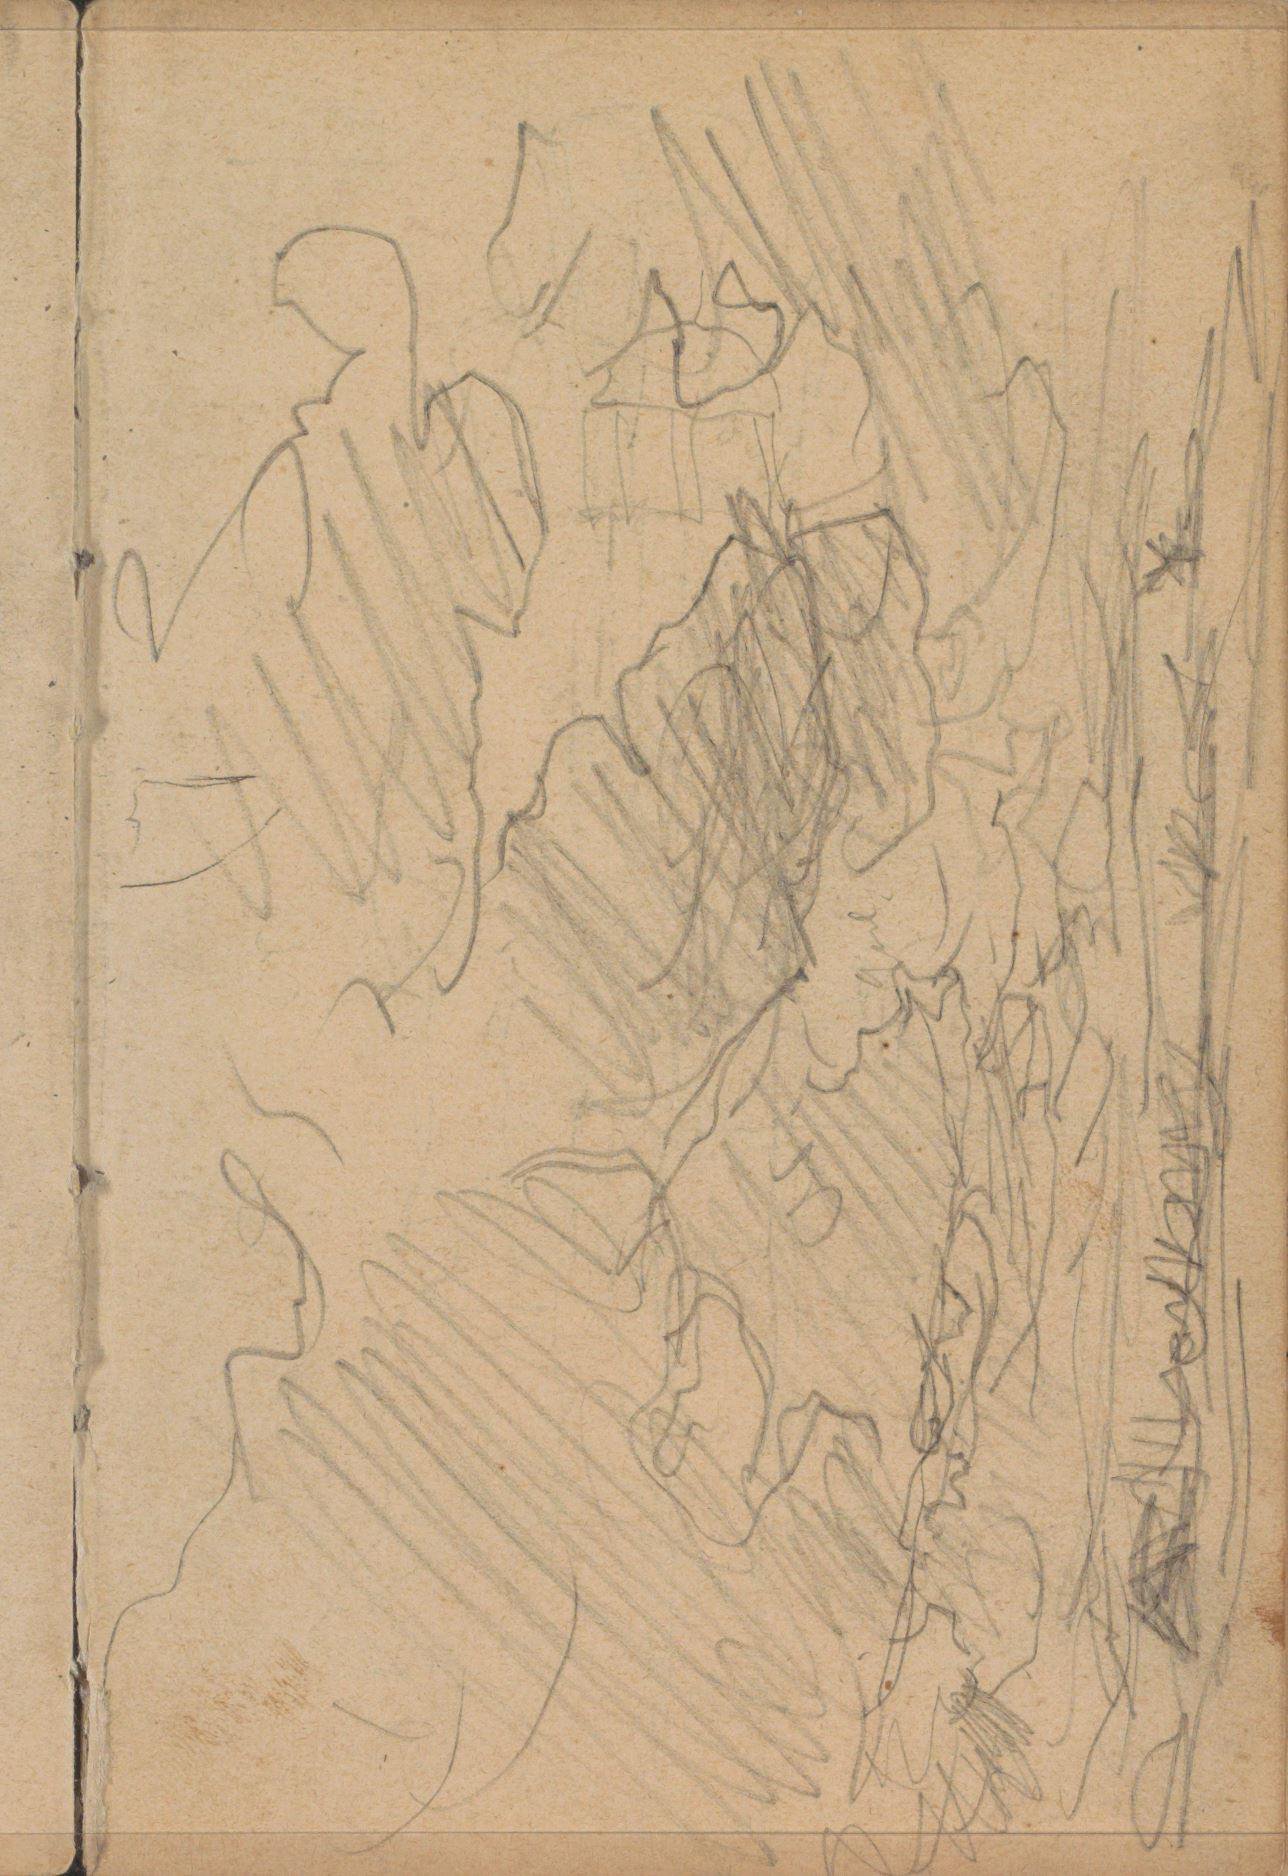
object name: sketchbook leaf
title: Landschap met wolkenlucht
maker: george hendrik breitner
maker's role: draughtsman, painter, print maker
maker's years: 1857-1923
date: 1886-1908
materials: paper, pencil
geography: north holland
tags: landscapes, clouds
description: Pagina 22 uit een schetsboek met 46 bladen vervaardigd te Amsterdam, Haarlem en Antwerpen.